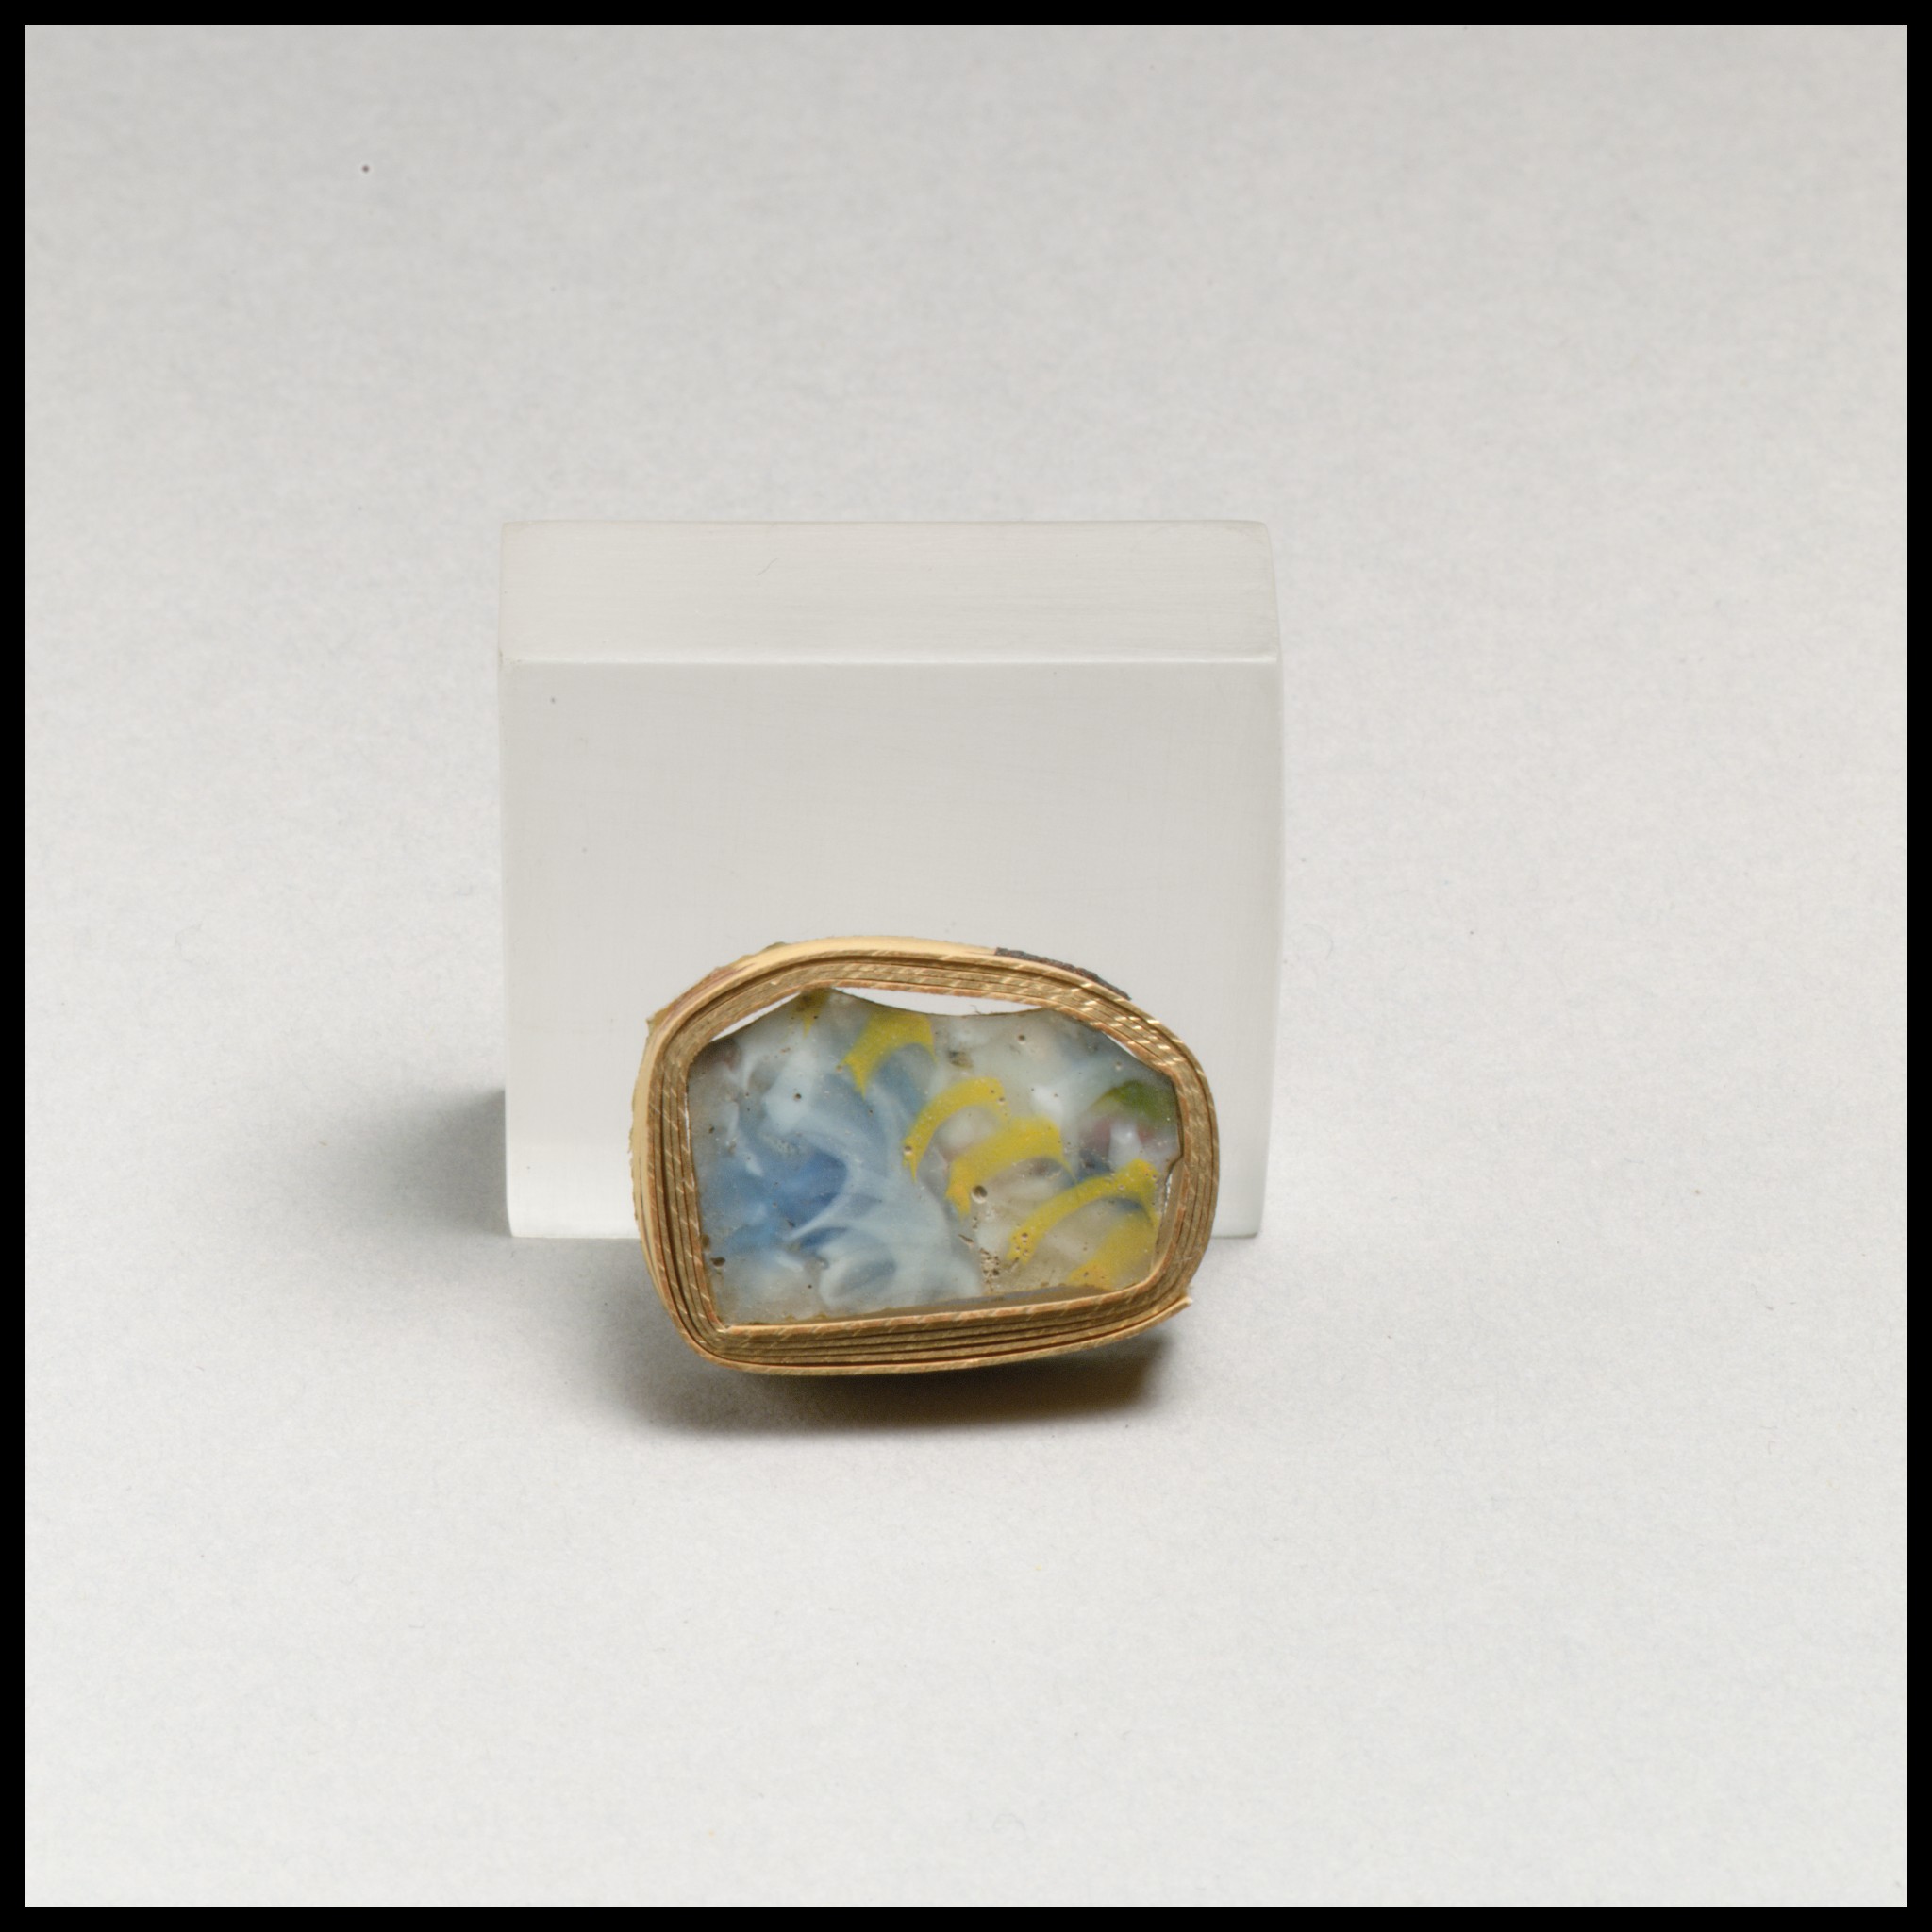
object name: fragment, mosaic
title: Glass mosaic fragment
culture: roman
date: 34 BCE-33 CE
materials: glass